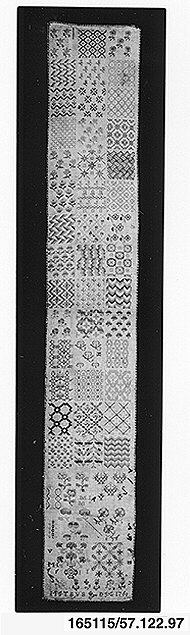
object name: sampler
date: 1701-1800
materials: linen, silk